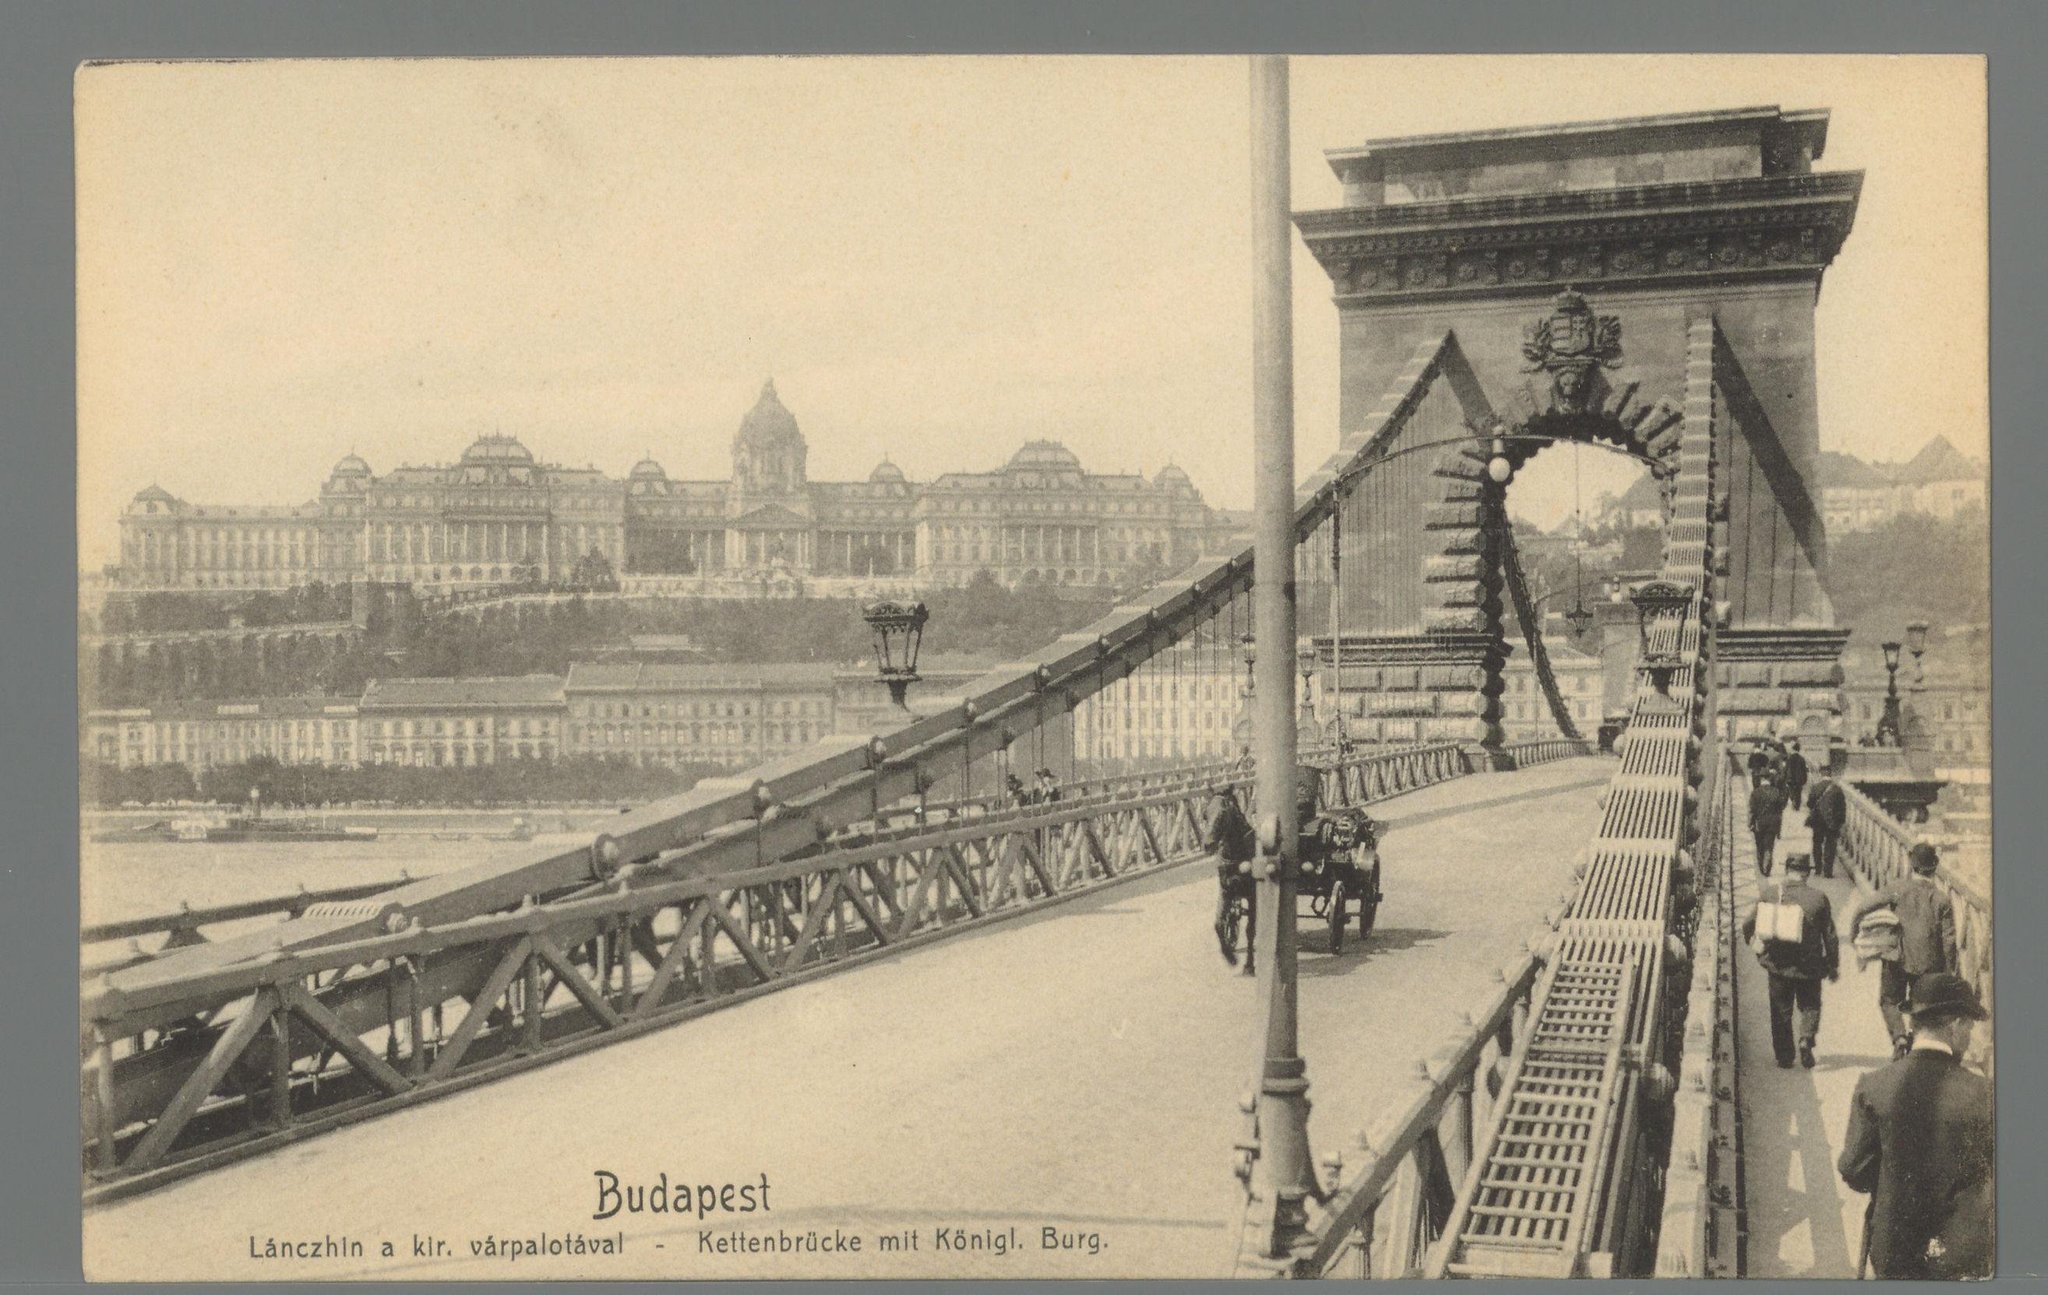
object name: photomechanical print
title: Budapest. Lánczhin a kir. várpalotával / Kettenbrücke mit Königl. Burg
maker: Anonymous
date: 1905-1930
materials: cardboard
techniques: photograph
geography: budapest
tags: castle, bridge in city across river, canal, etc.